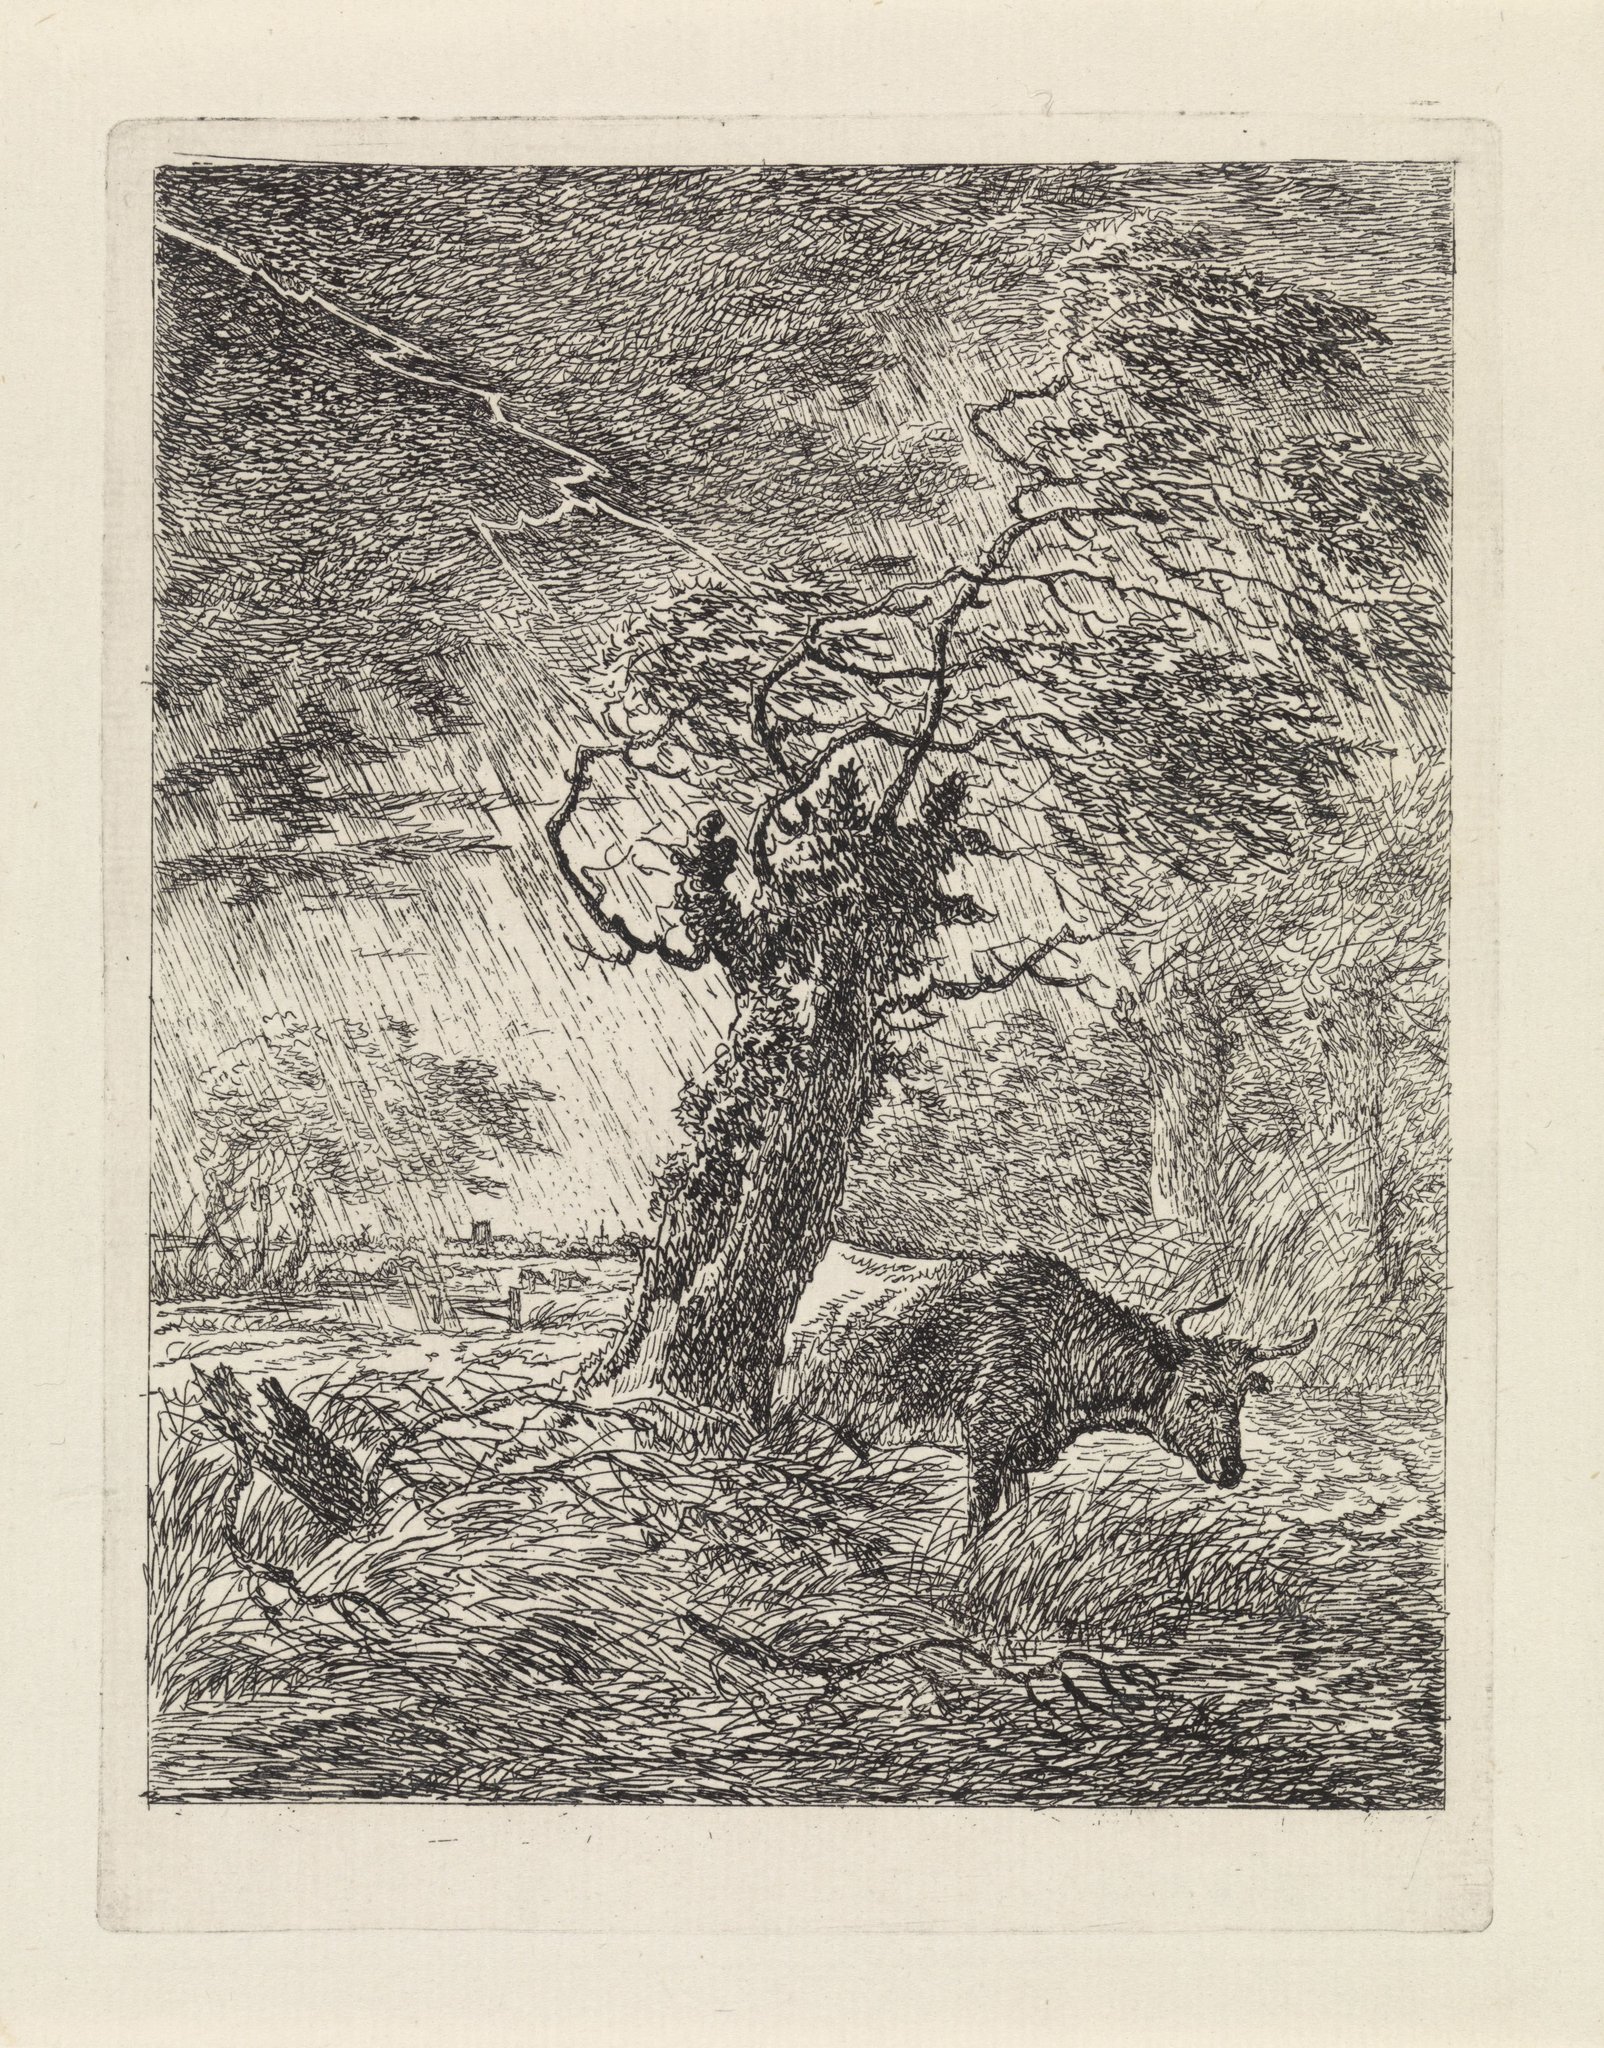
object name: print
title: Landschappen (serie B)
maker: gerard van nijmegen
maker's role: draughtsman, painter, print maker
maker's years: 1735-1808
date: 1790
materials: paper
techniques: etching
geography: rotterdam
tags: cow, rain, lightning, flash of lightning, thunderbolt, trees: willow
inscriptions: collector's mark: Lugt 2228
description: In een landschap staat een koe bij een knotwilg. Het bliksemt, regent en waait.